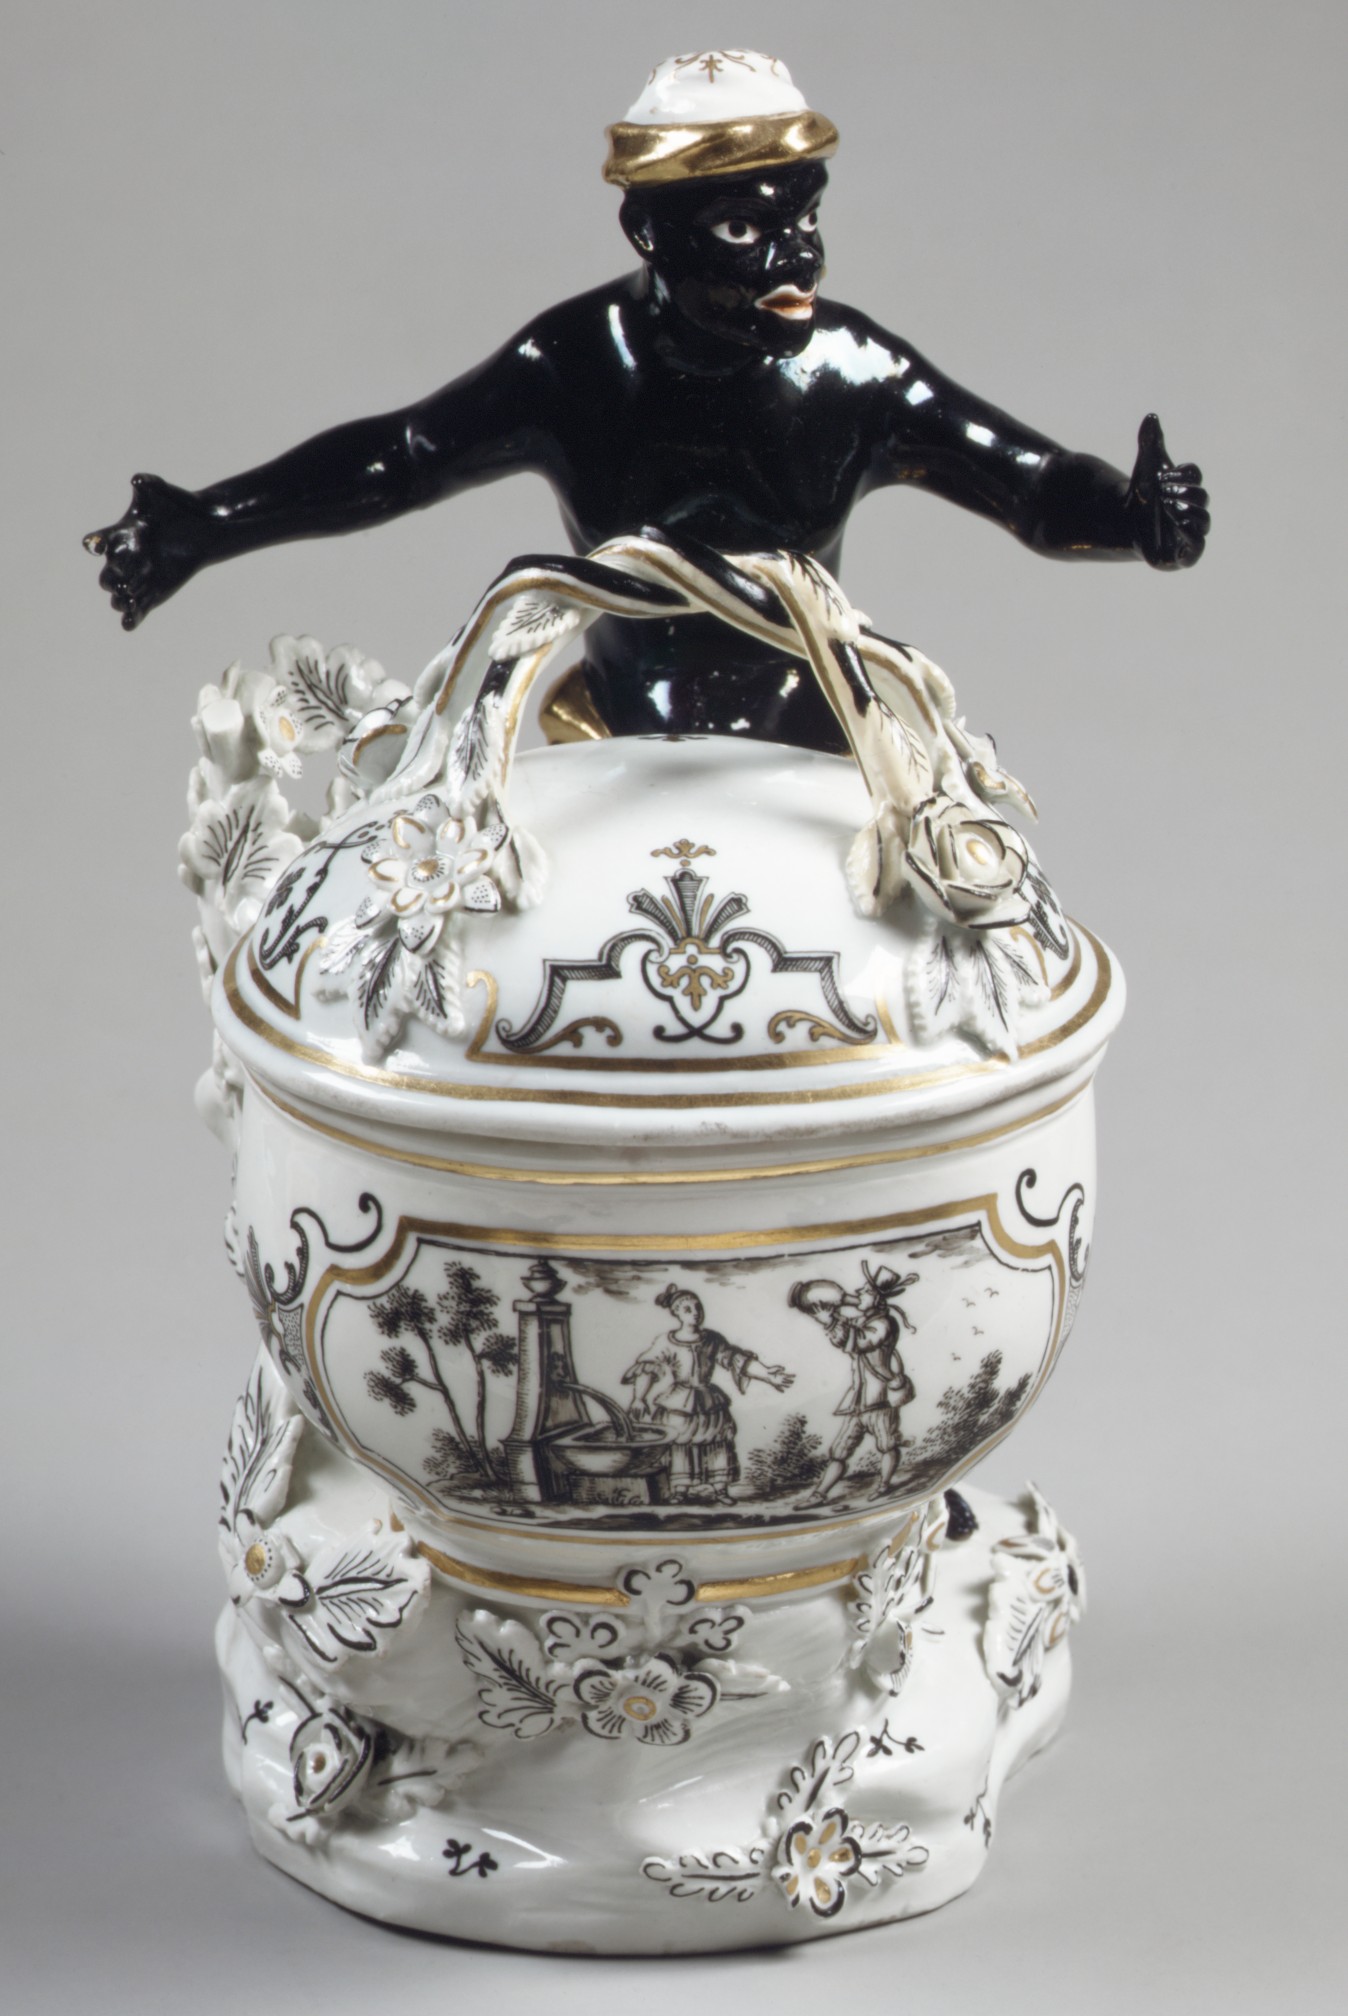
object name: sugar box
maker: vienna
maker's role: manufactory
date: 1741-1744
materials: hard paste porcelain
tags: men,flowers,leaves